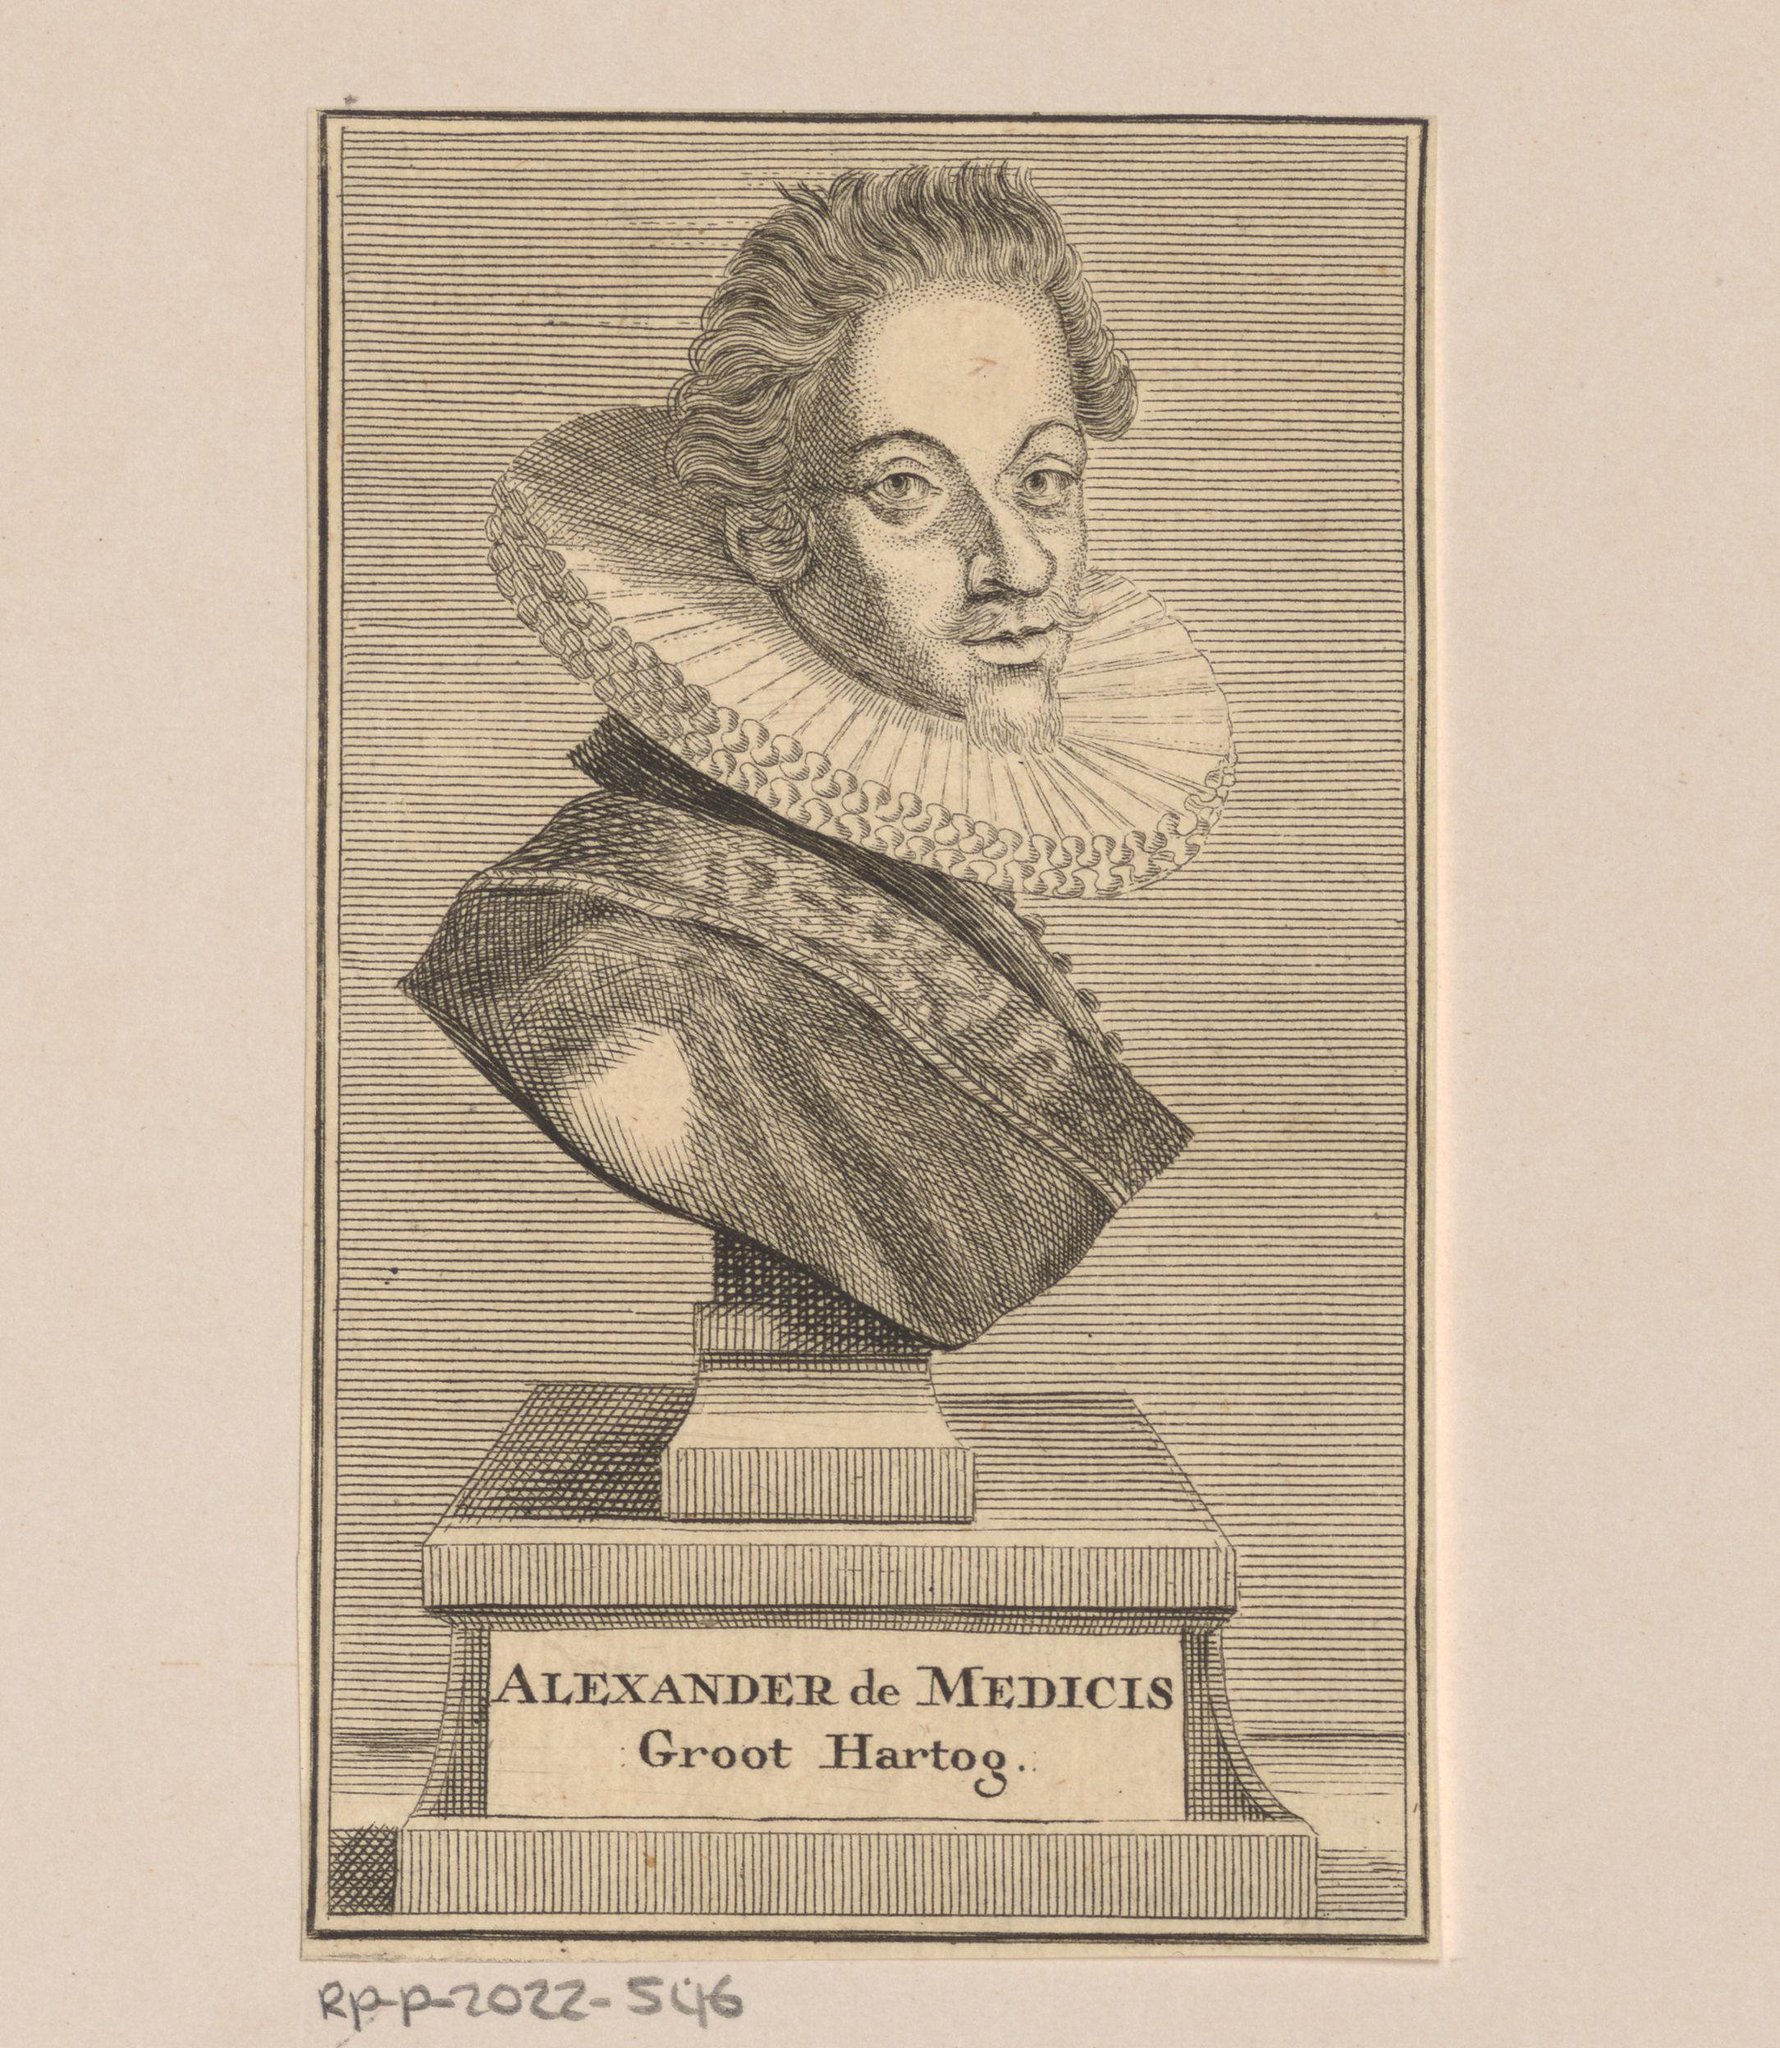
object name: print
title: Alexander de Medicis Groot Hartog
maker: Anonymous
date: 1600-1700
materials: paper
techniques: engraving, etching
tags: historical persons